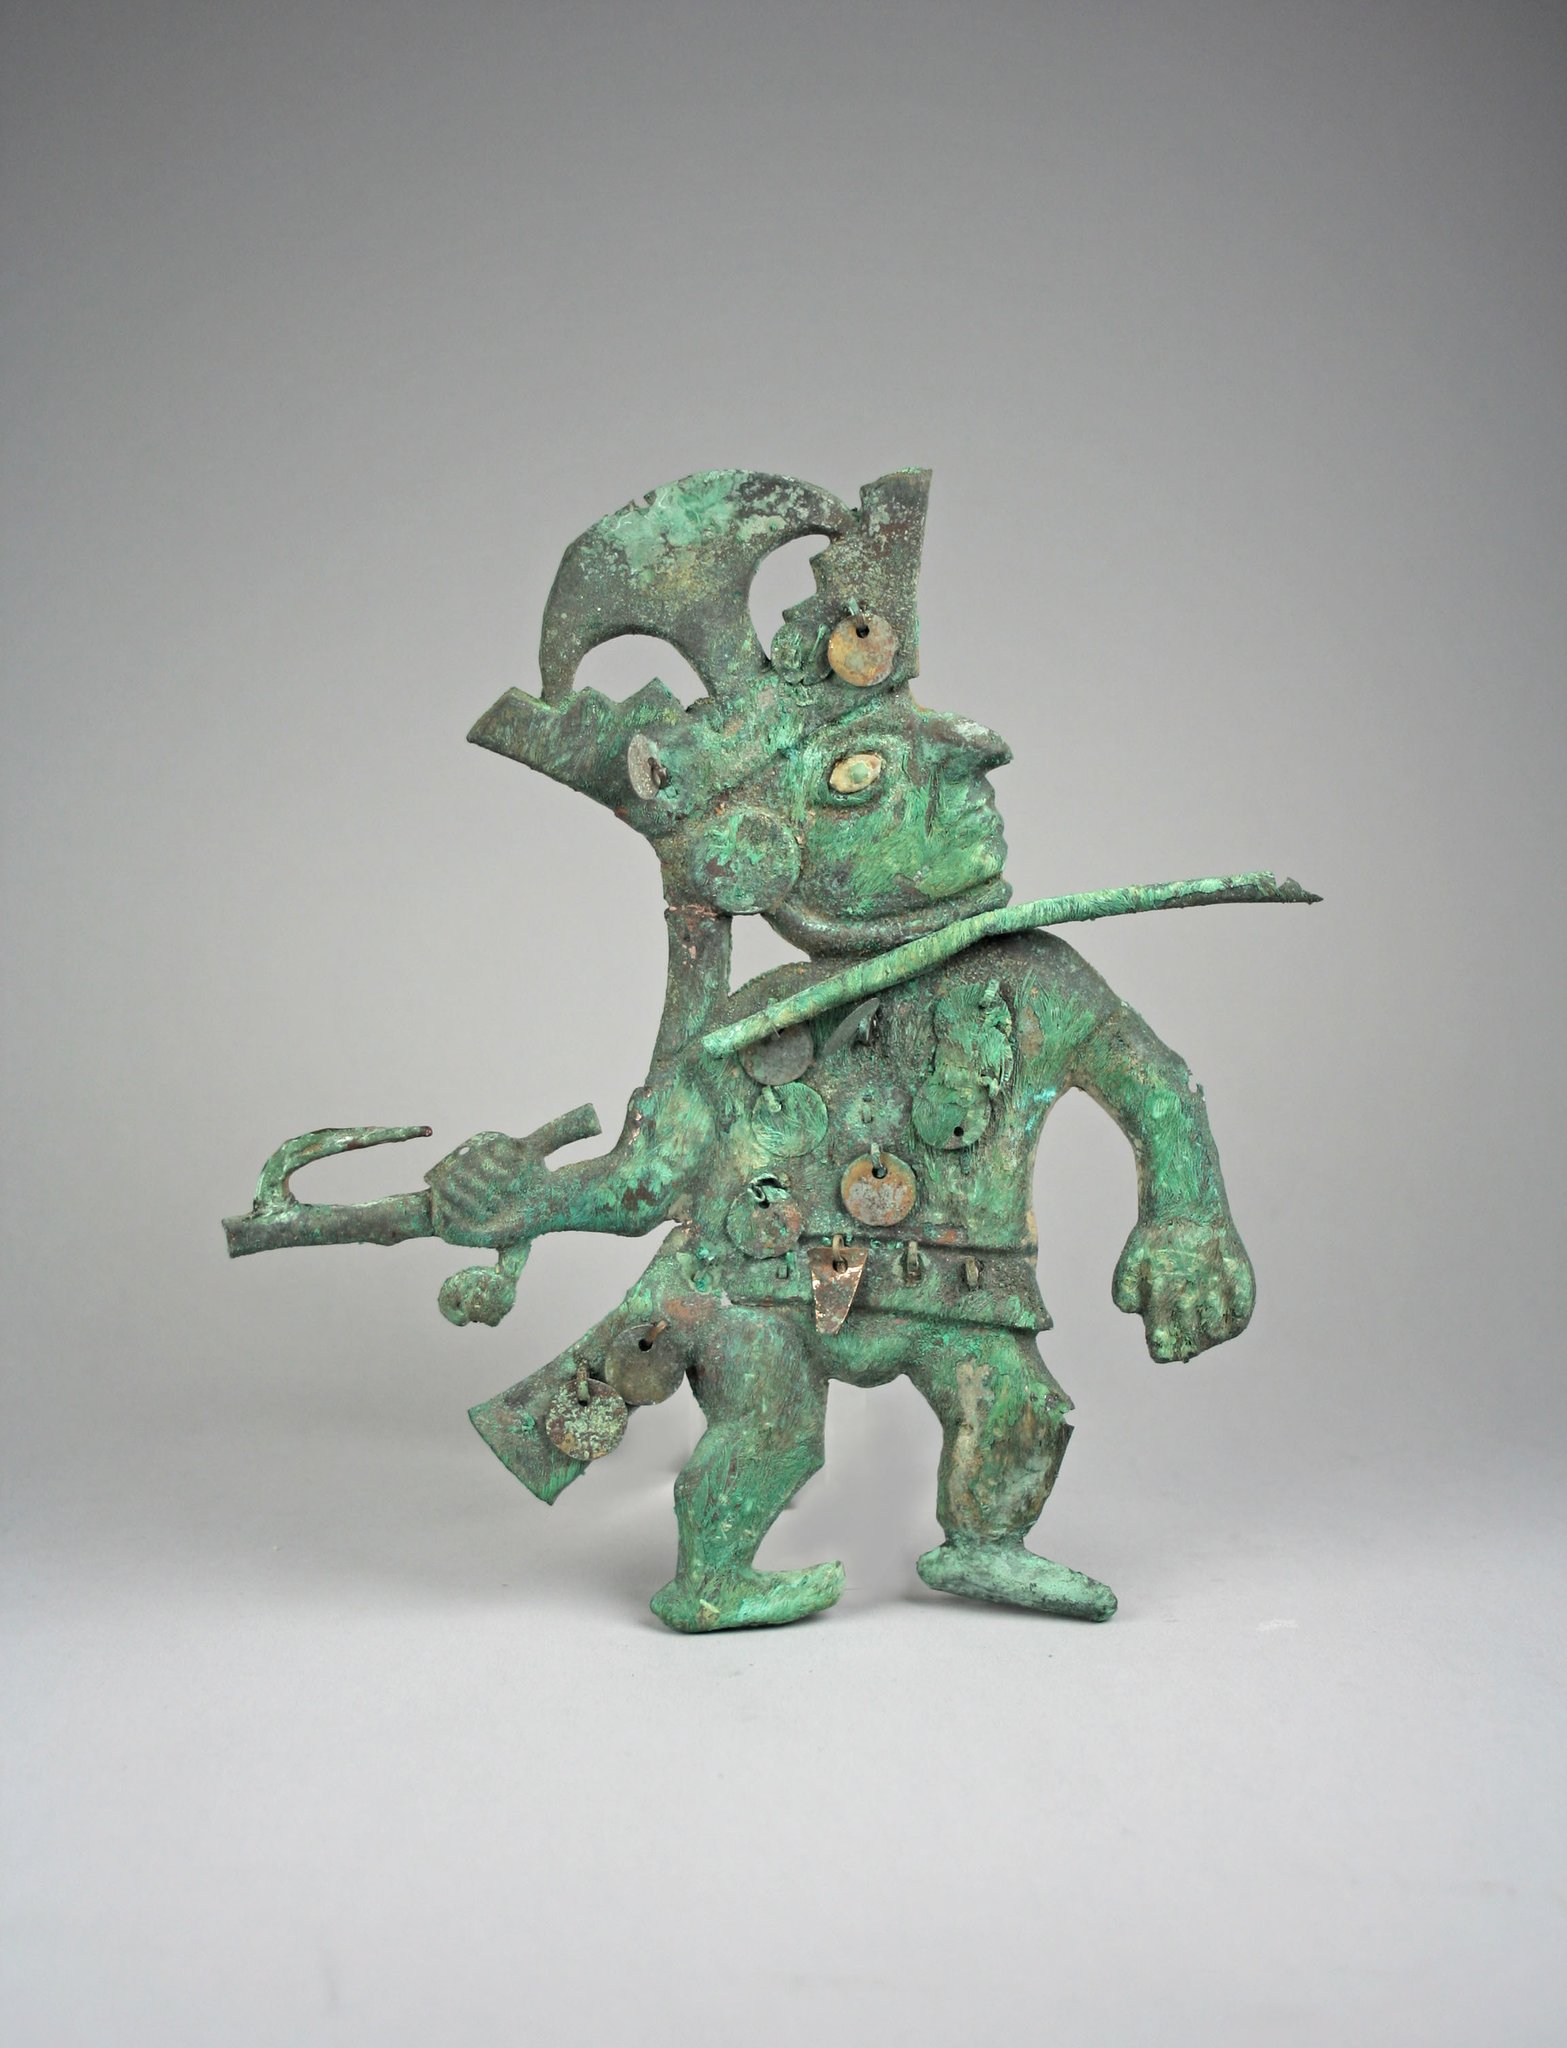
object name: ornament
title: Profile Warrior Ornament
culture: moche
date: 501-700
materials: gilt copper, shell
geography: peru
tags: spears,warriors